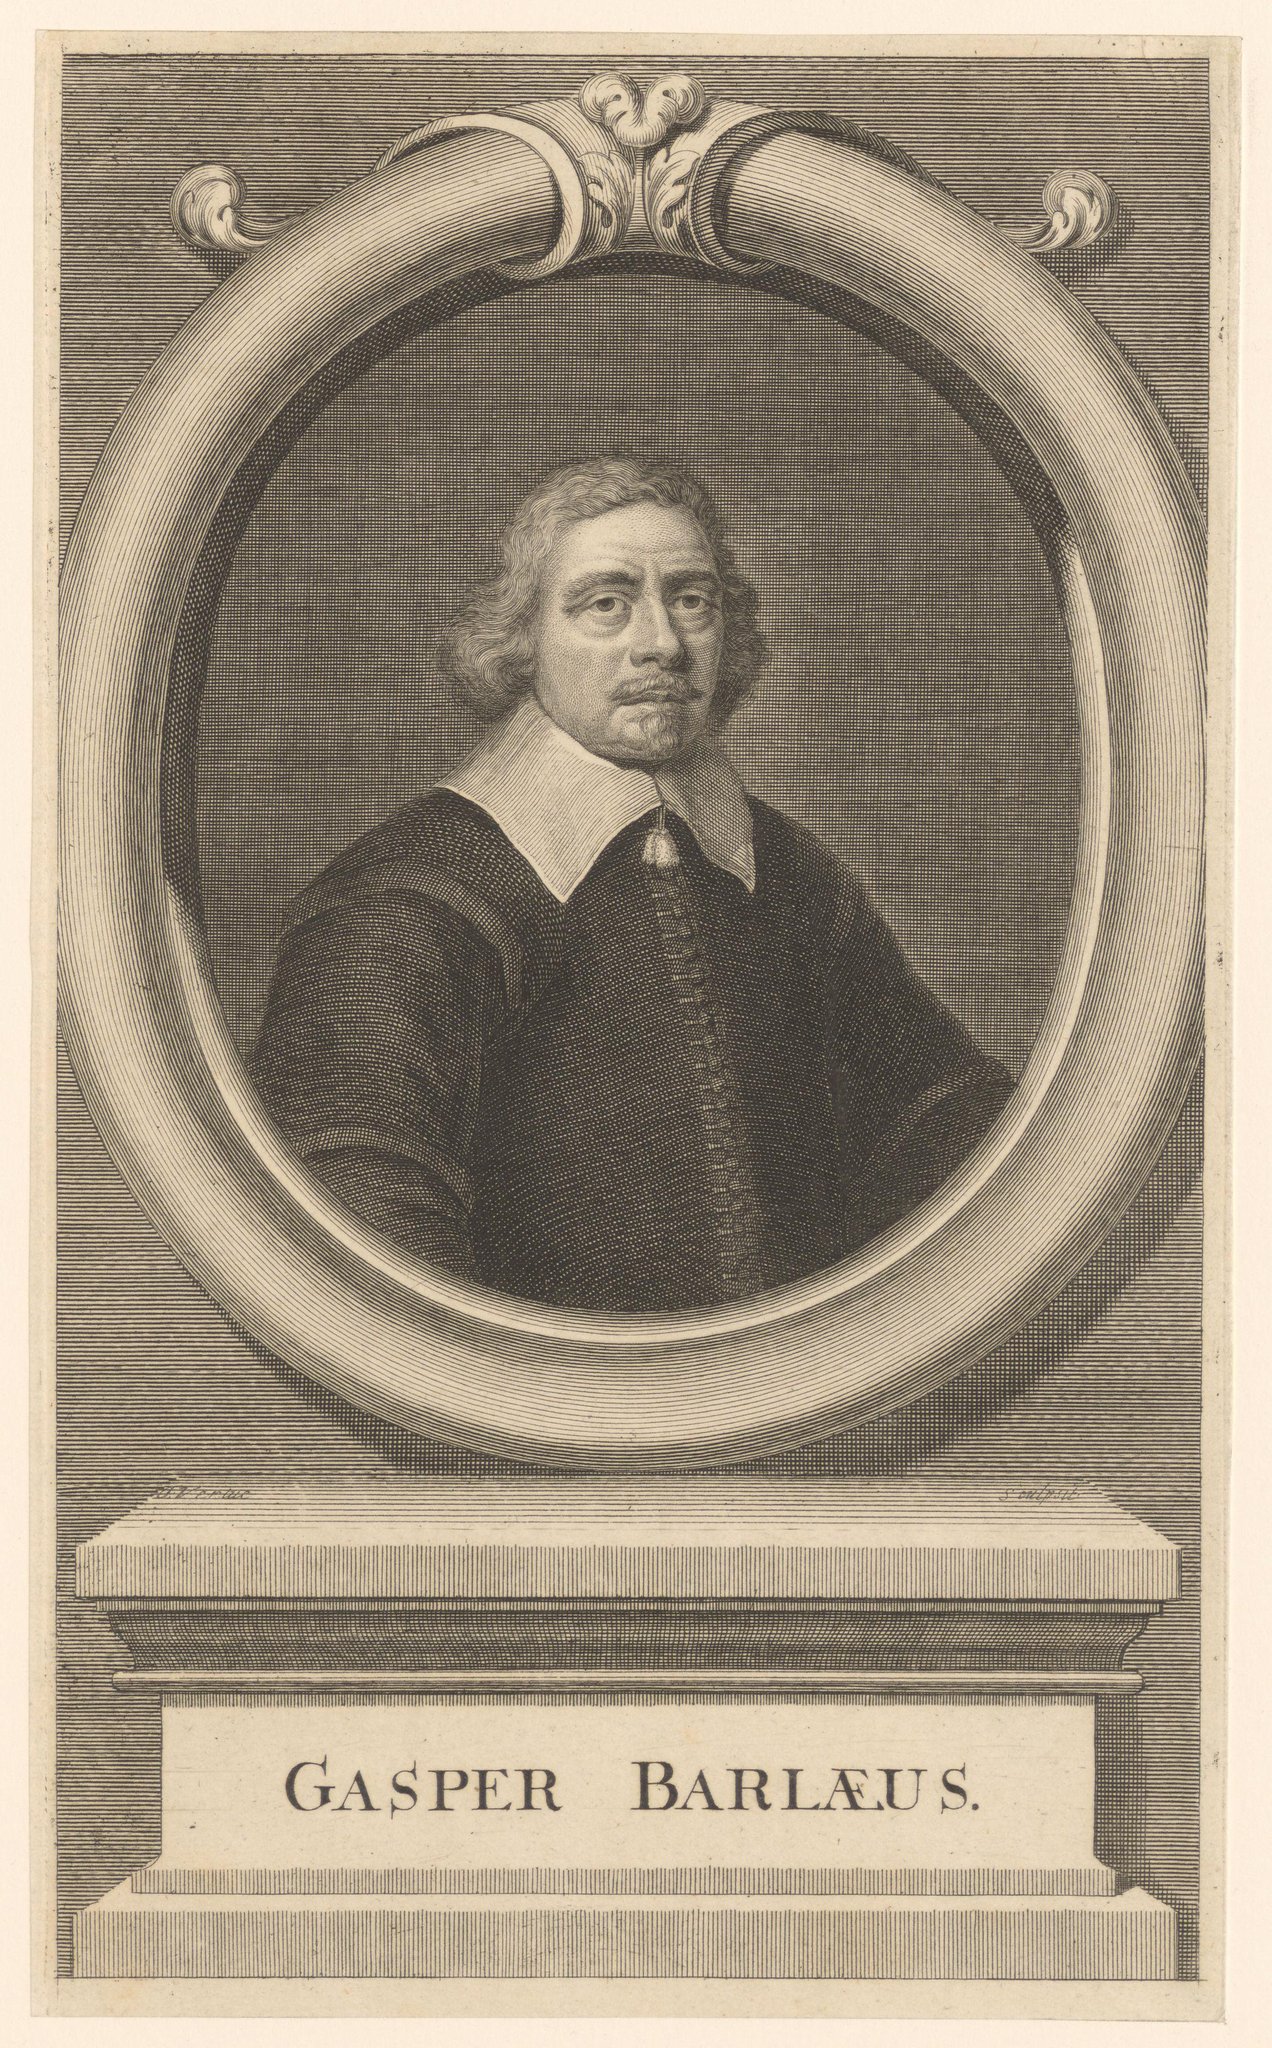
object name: print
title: Portret van Caspar van Baerle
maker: george vertue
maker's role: print maker, publisher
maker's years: 1684-1756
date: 1694-1756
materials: paper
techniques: engraving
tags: antwerp, caspar van baerle, historical persons, portrait of a writer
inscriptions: collector's mark: Lugt 2228